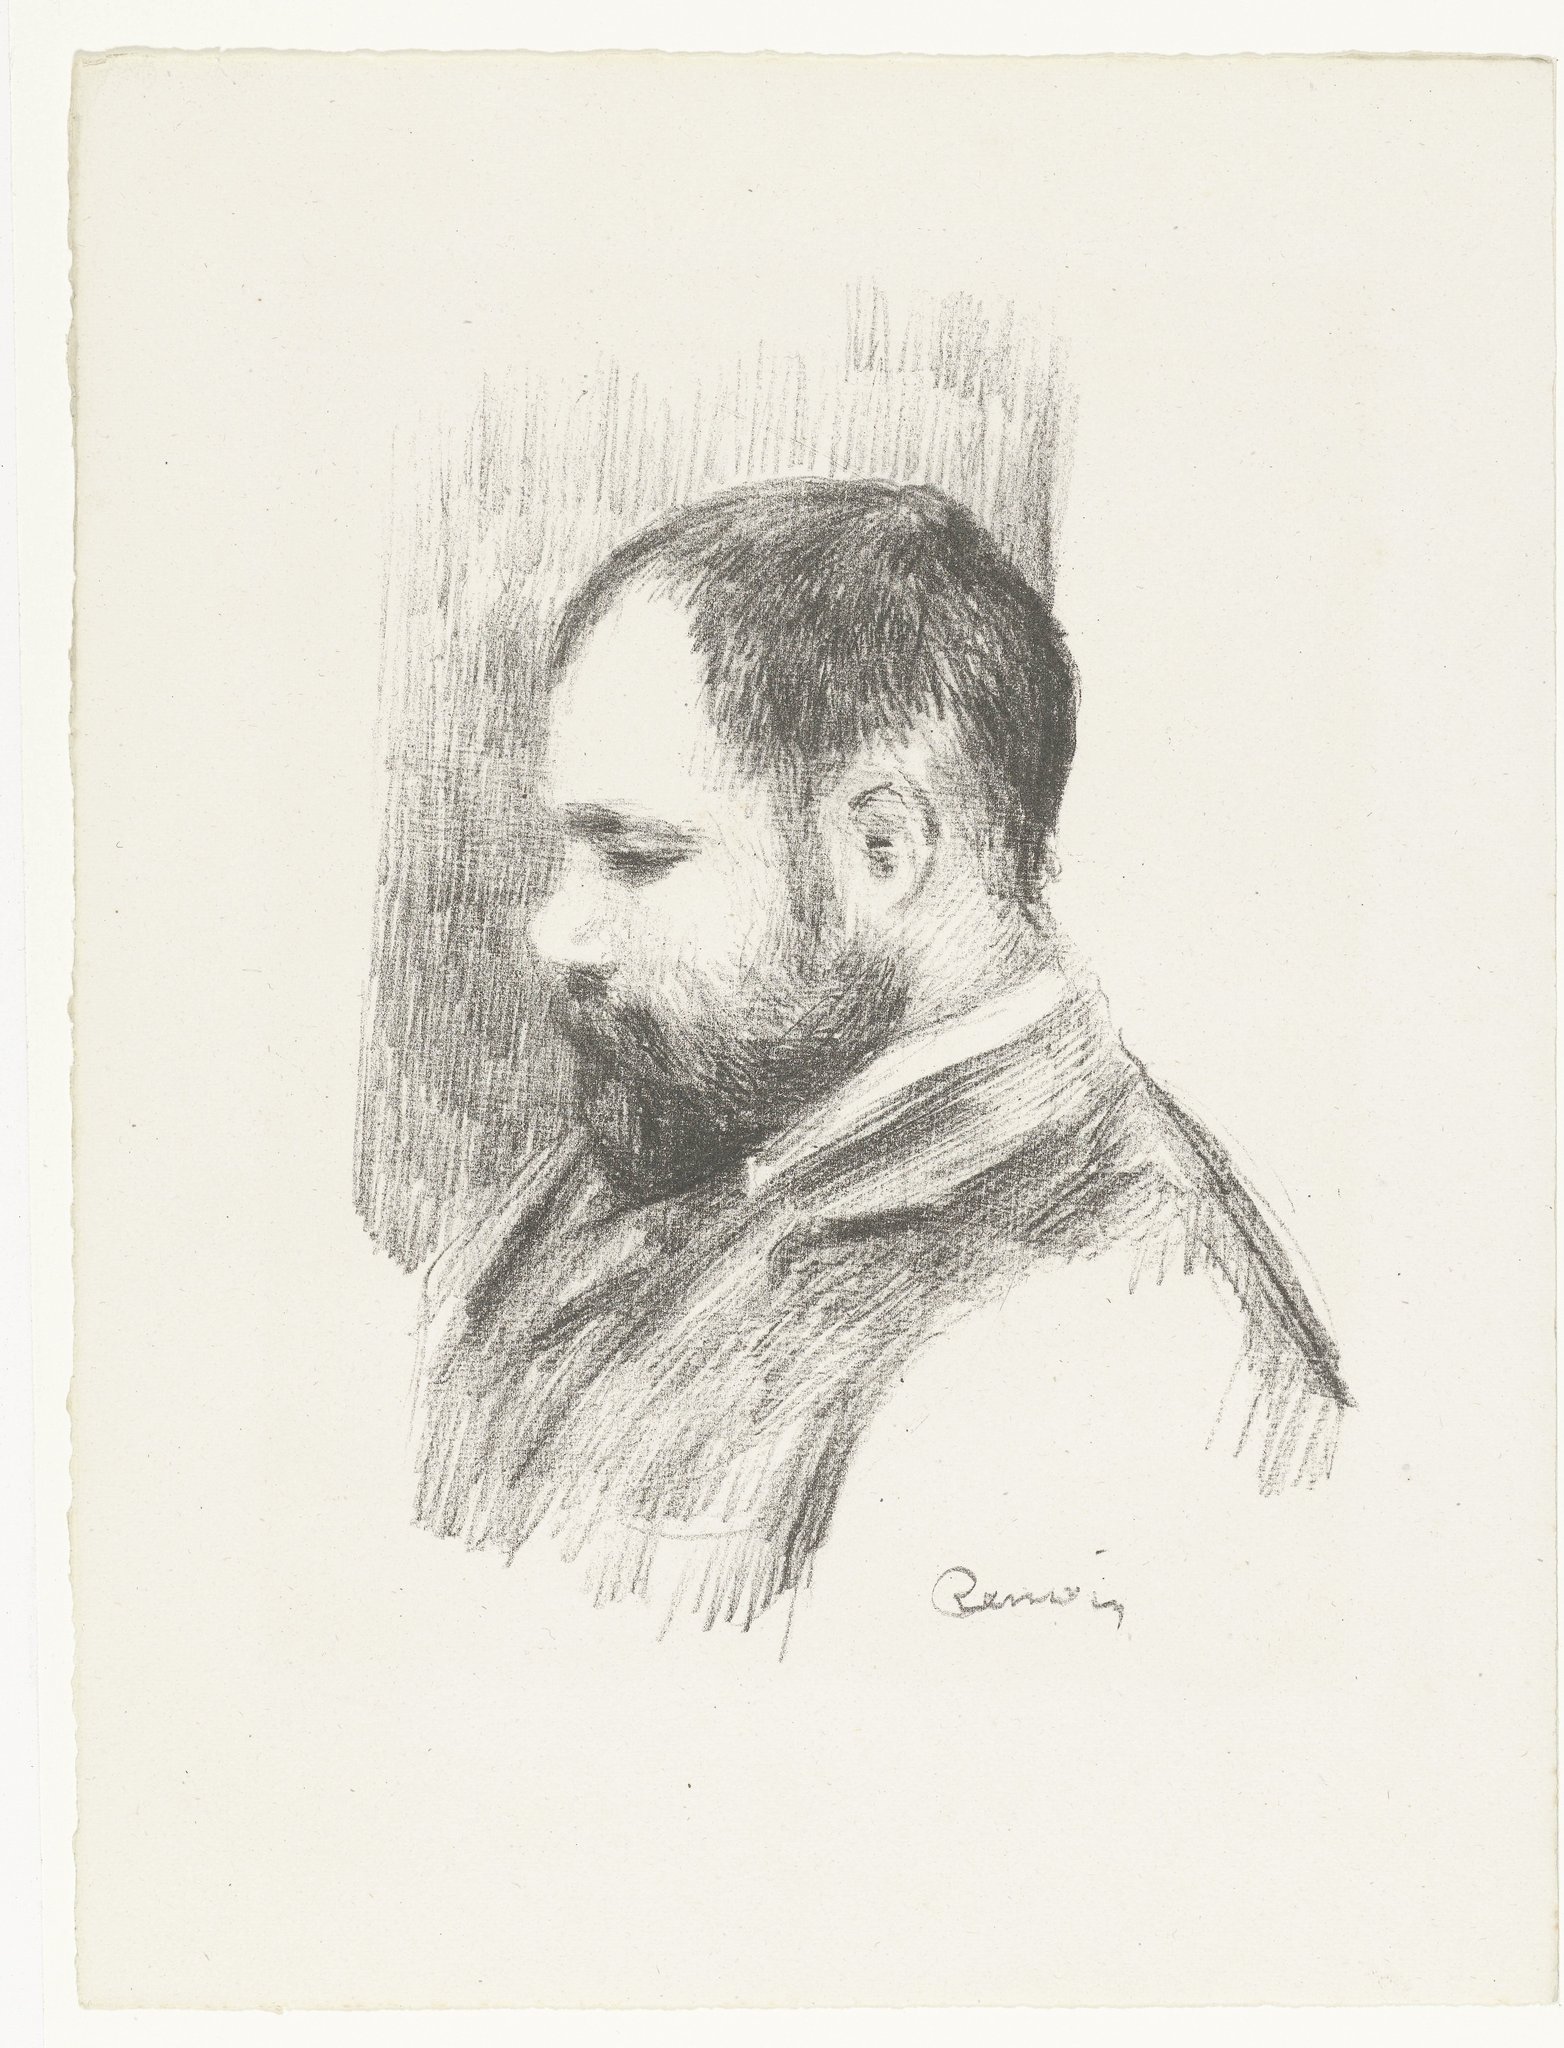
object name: print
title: Portret van kunsthandelaar Ambroise Vollard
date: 1904-1905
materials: paper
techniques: lithograph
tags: henri louis ambroise vollard, portrait of a writer, publishing, publisher, art dealer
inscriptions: collector's mark: Lugt 2228, collector's mark: Lugt 2760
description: Lithografie gepubliceerd in: Douze lithographies originales de Pierre-Auguste Renoir, Auguste Clot (drukker), Ambroise Vollard (uitgever), Parijs 1919